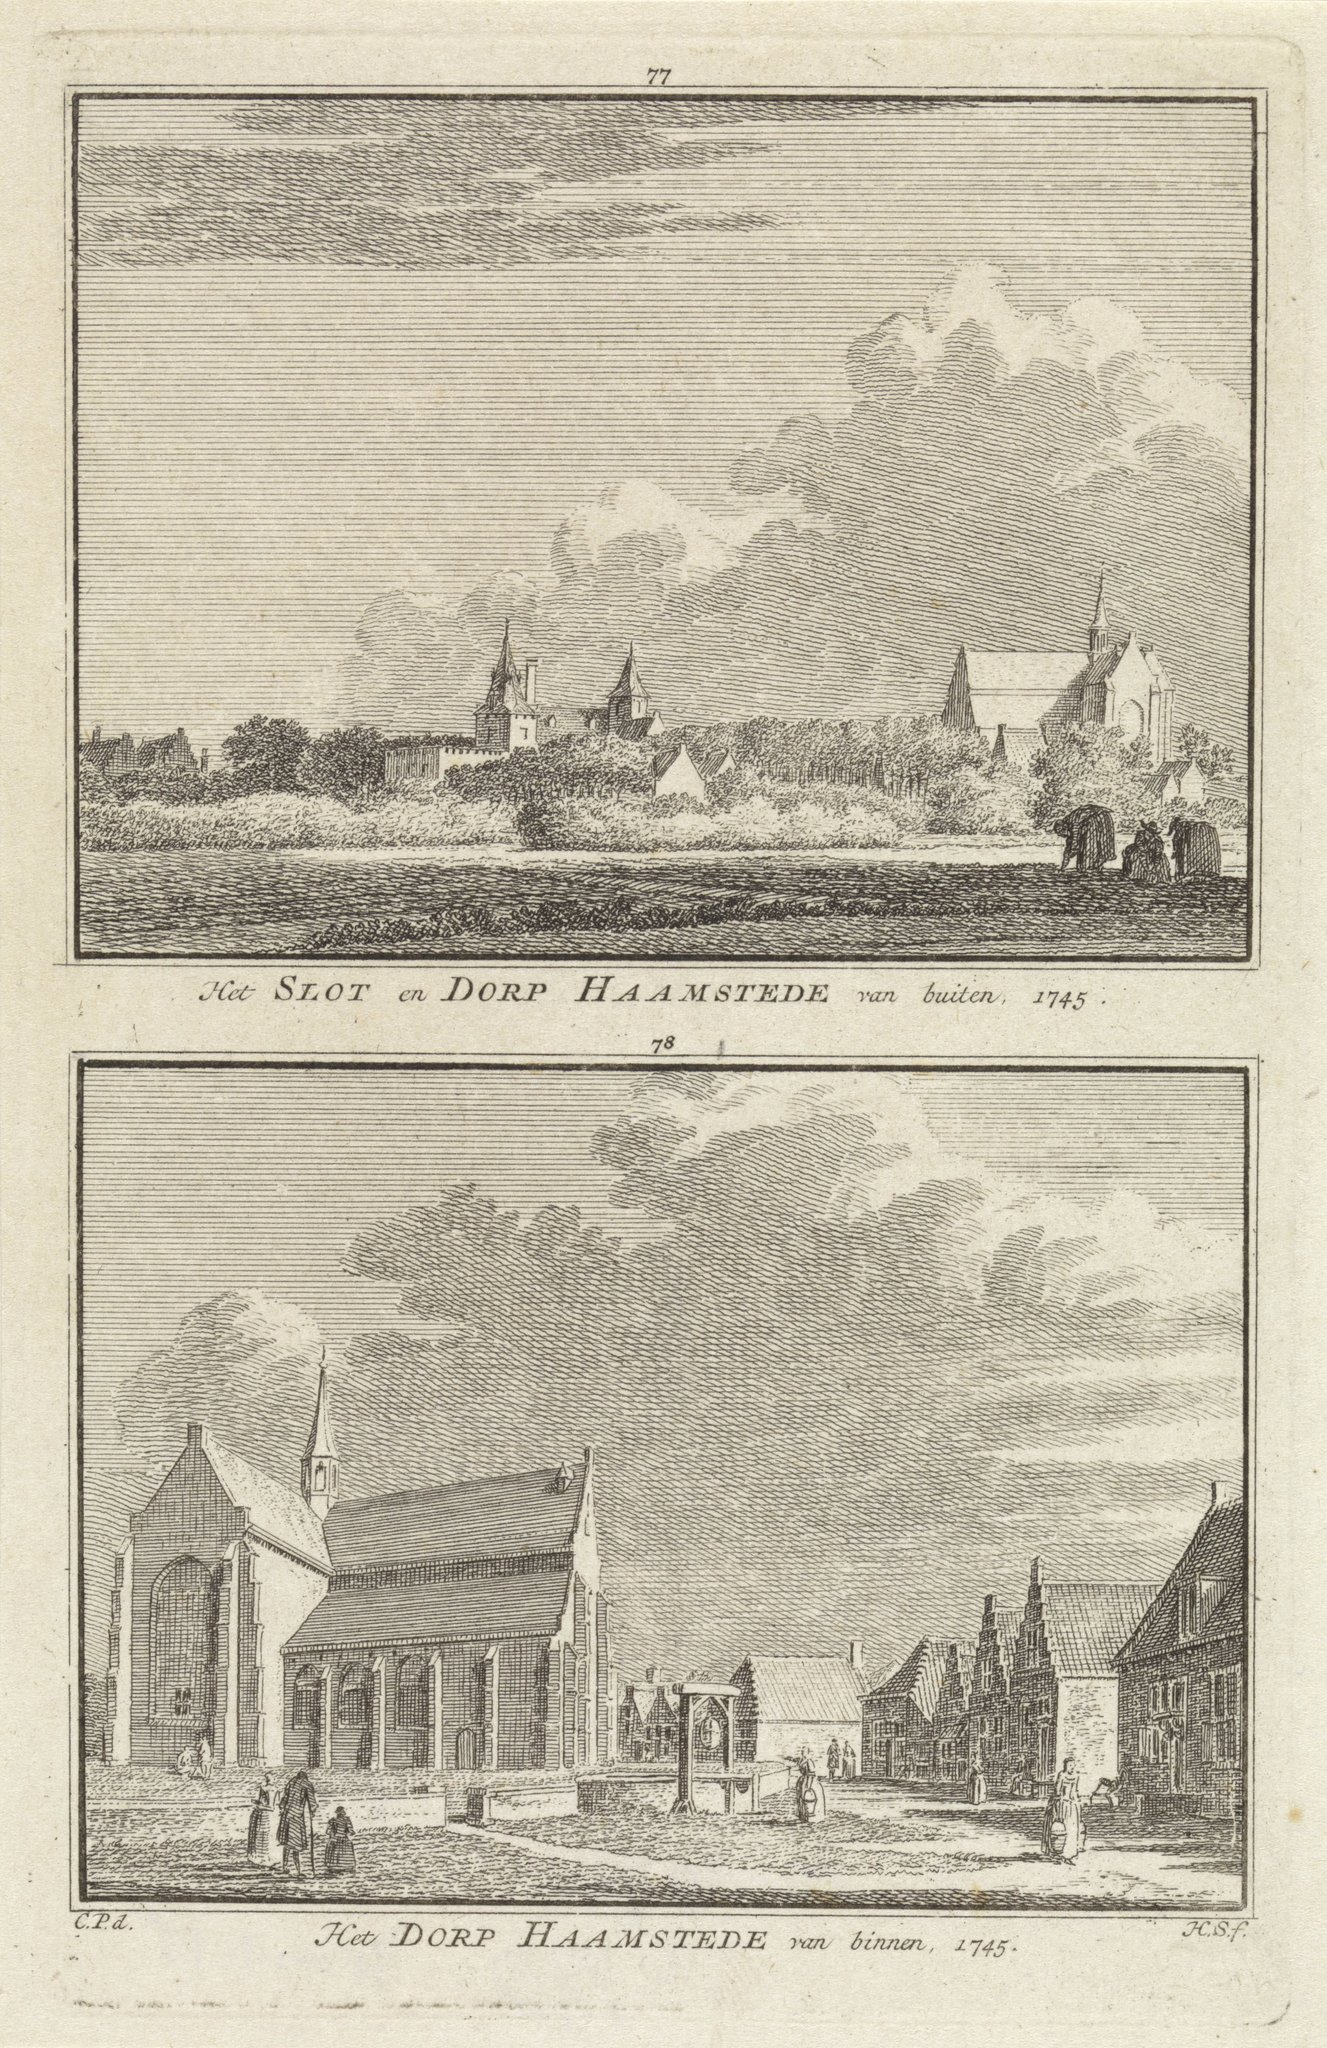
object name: book illustration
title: Het Slot en Dorp Haamstede van buiten, 1745/ Het Dorp Haamstede van binnen, 1745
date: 1754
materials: paper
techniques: etching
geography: haarlem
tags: prospect of village, silhouette of village, castle, church (exterior), public road in village, slot haamstede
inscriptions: collector's mark: Lugt 2228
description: Prent gebruikt in: Het verheerlykt Nederland of kabinet van hedendaagsche gezigten van steden, dorpen, sloten ... en andere voornaame stad- en landgebouwen, in en omtrent alle de byzondere Vereenigde Nederlandsche Provinciën : gedurende de laatste jaaren door vermaarden kunsttekenaren na het leven getekent en ... in 't koper gebragt ... dienende tot opheldering der beschryvinge van den Tegenwoordigen Staat der Vereenigde Nederlanden. Deel V, 1754. Amsterdam: Isaac Tirion, 1745-1774.